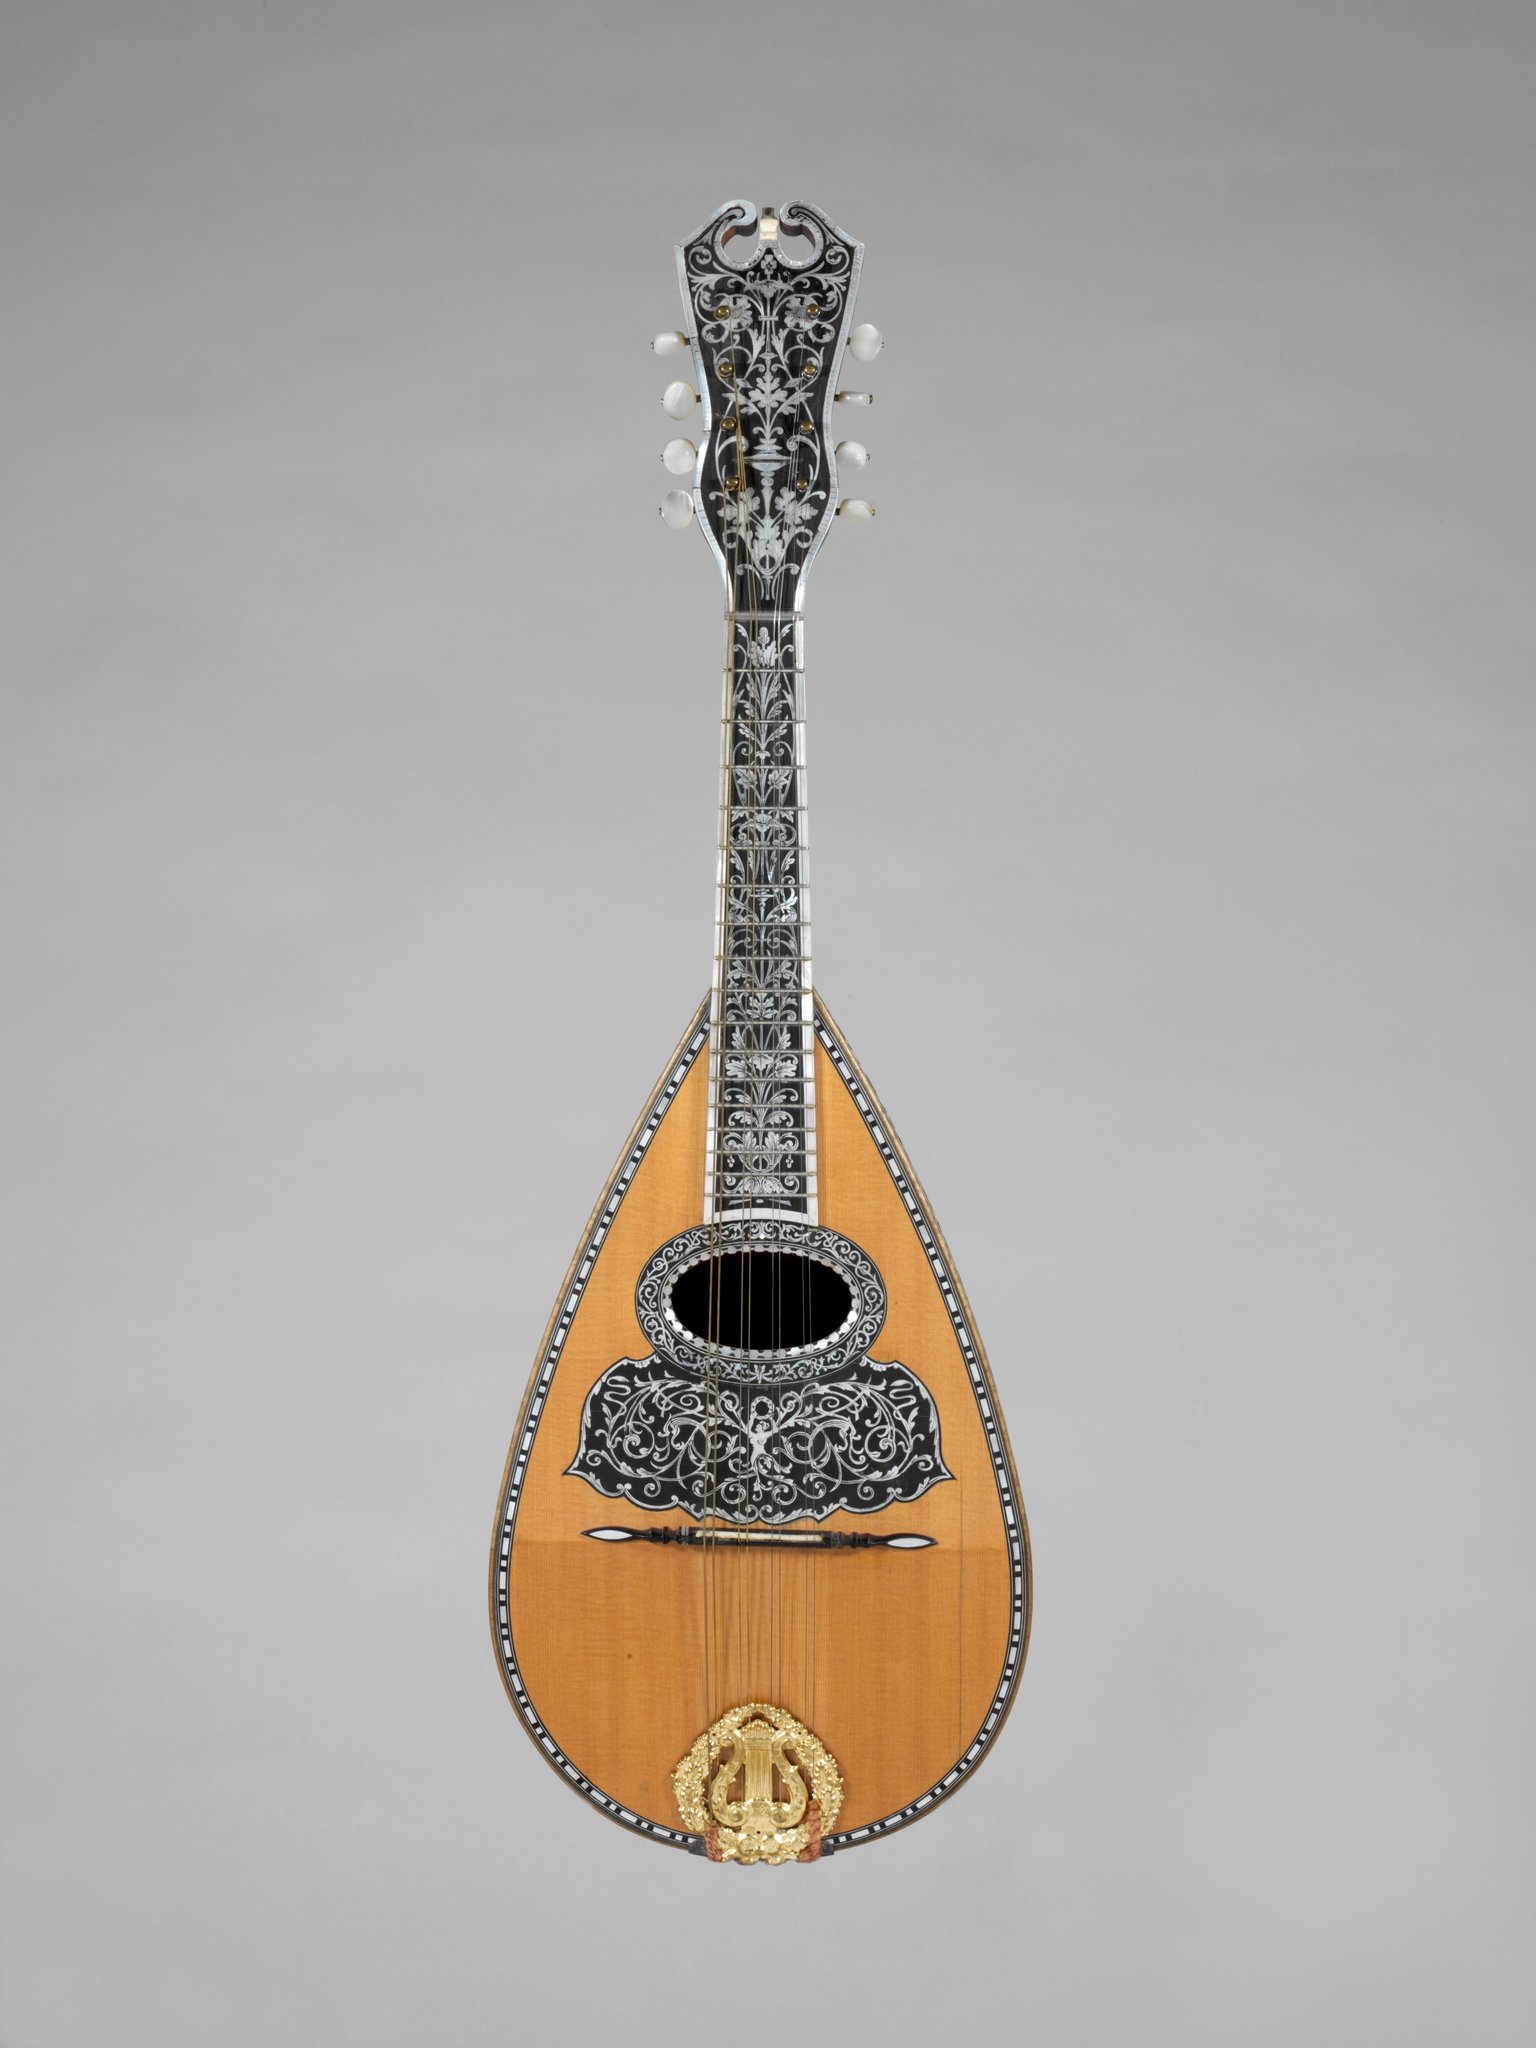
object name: mandolin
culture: american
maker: angelo mannello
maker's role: maker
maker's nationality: american, born italy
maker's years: 1858-1922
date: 1900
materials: ivory, wood, metal, mother of pearl, shell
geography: united states